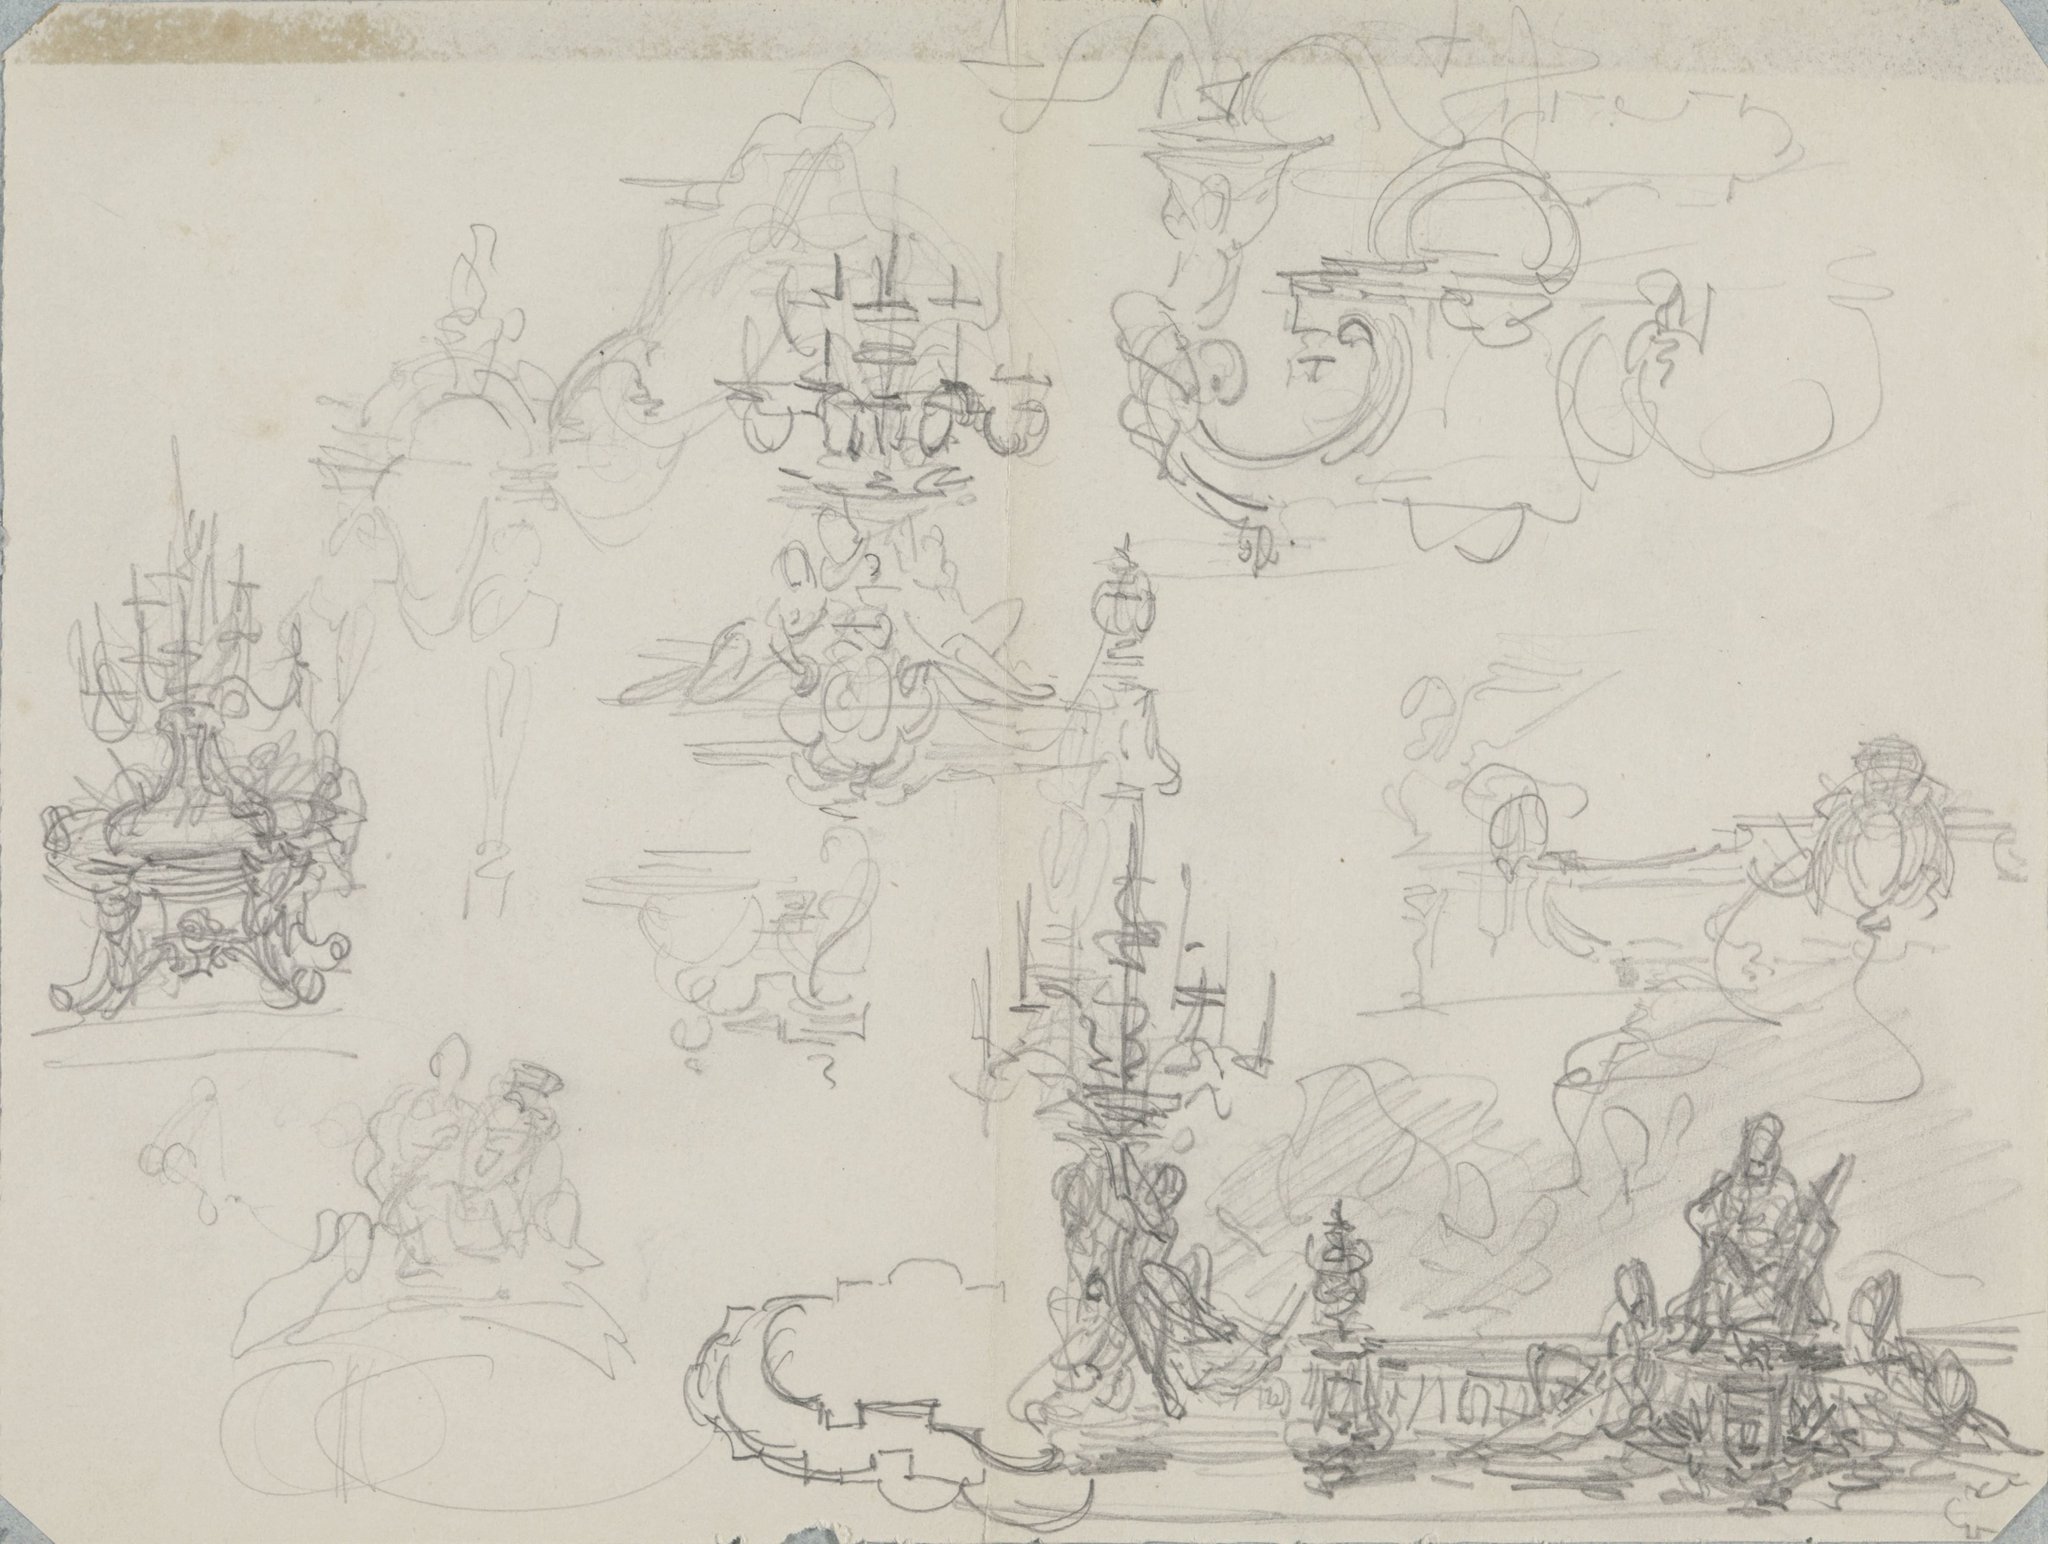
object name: design drawing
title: Ontwerpen voor tafelstukken, kandelabers en jardinières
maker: henri cameré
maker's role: designer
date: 1864-1894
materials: paper, pencil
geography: paris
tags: centre-piece, epergne, 'surtout', 'milieu-de-table', chandelier, candelabrum, potted plants